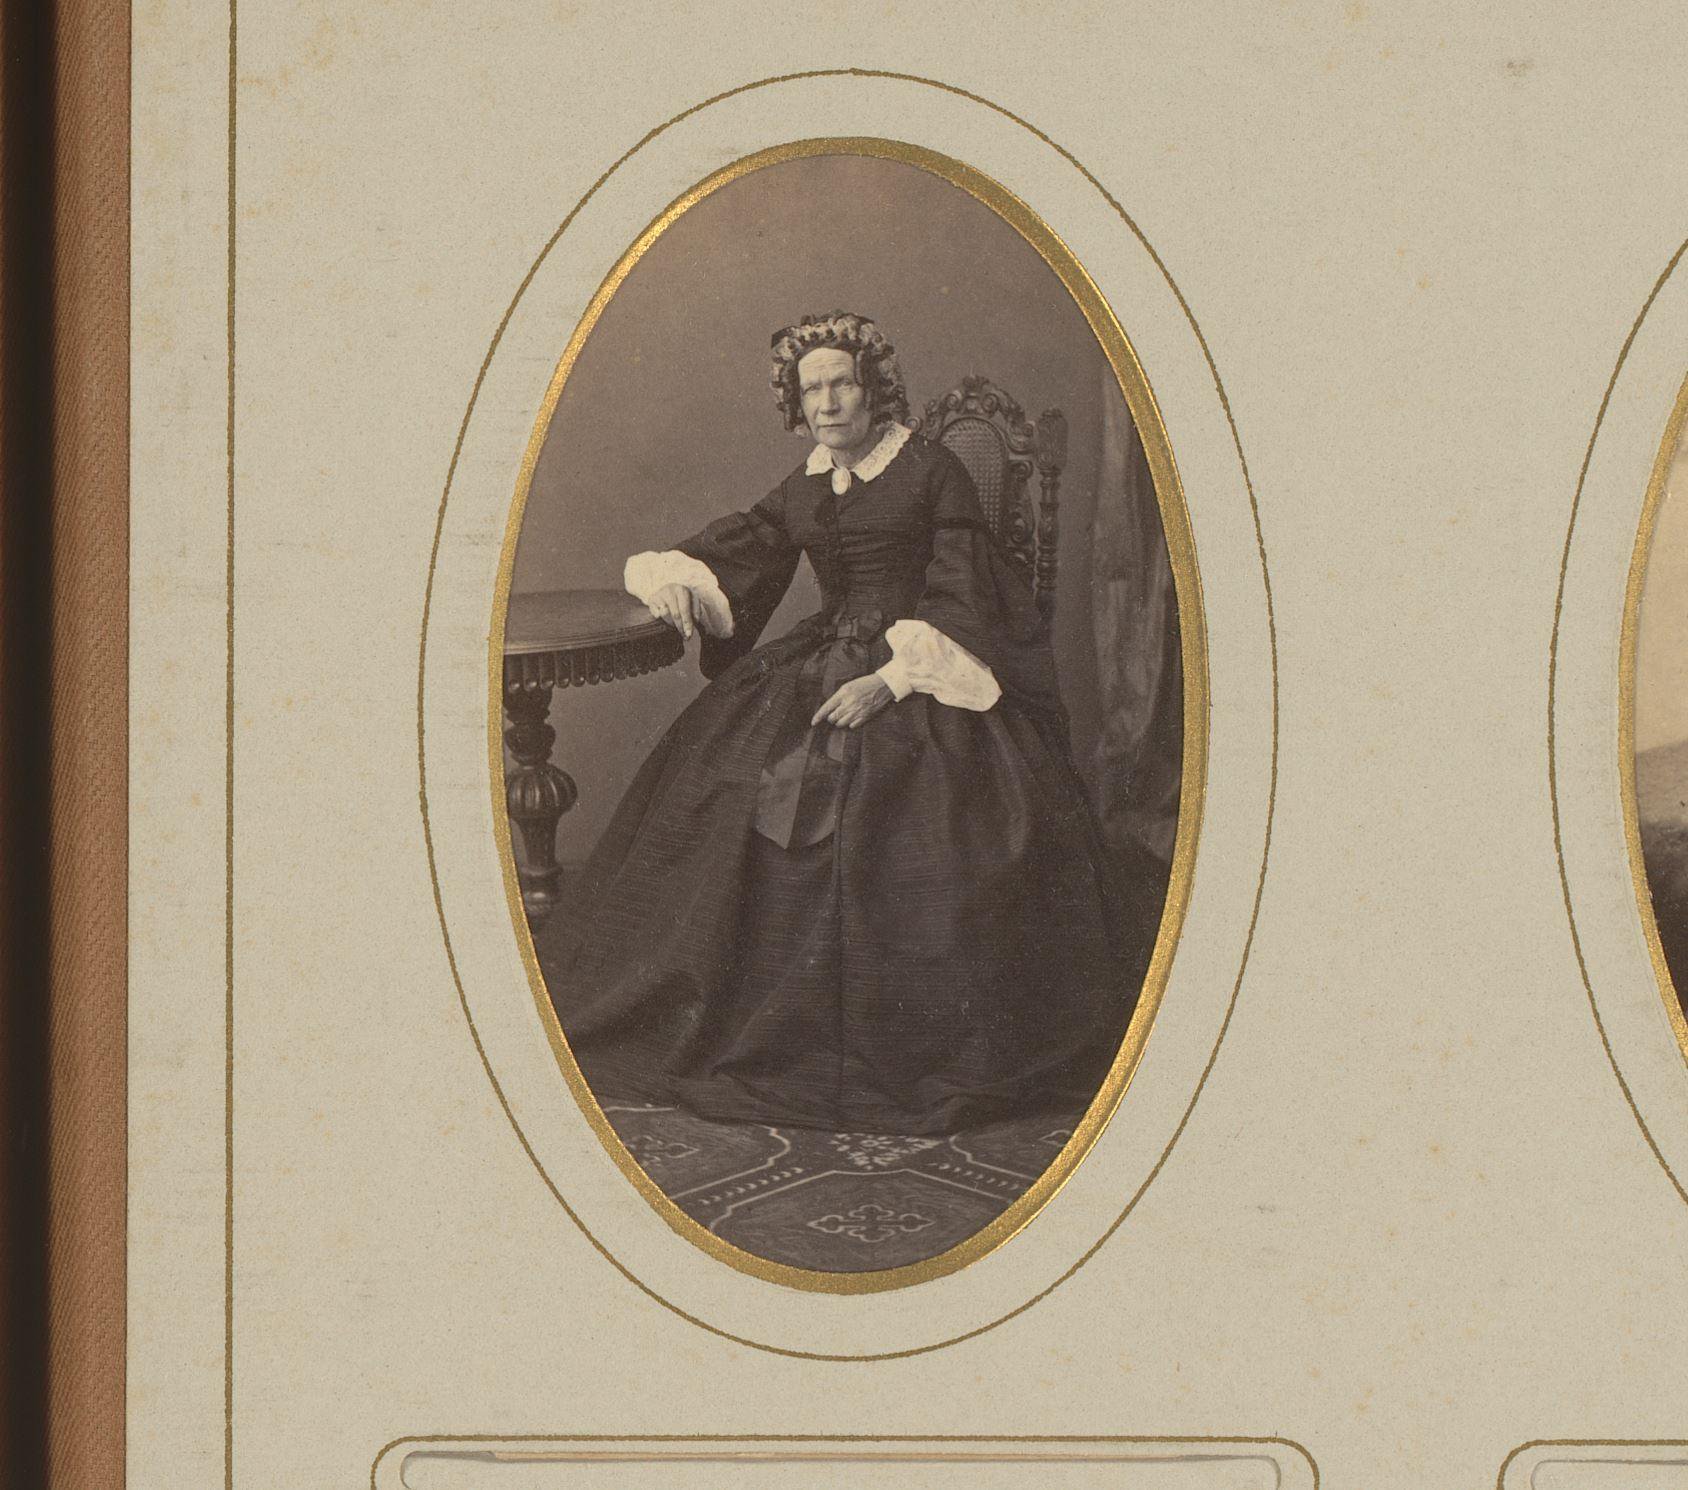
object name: photograph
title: Portret van een vrouw, zittend aan een tafel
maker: palmer descamps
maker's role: goldsmith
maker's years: 1840-1884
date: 1865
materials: cardboard, photographic support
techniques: albumen print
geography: kortrijk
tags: sitting figure - aa - female human figure, historical persons - bb - woman, table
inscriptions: inscription: ‘PHOTOGRAPHIE./ ORFÉVRERIE/ PALMER DESCAMPS,/ Rue de la Lys, 7/ COURTRAI.’